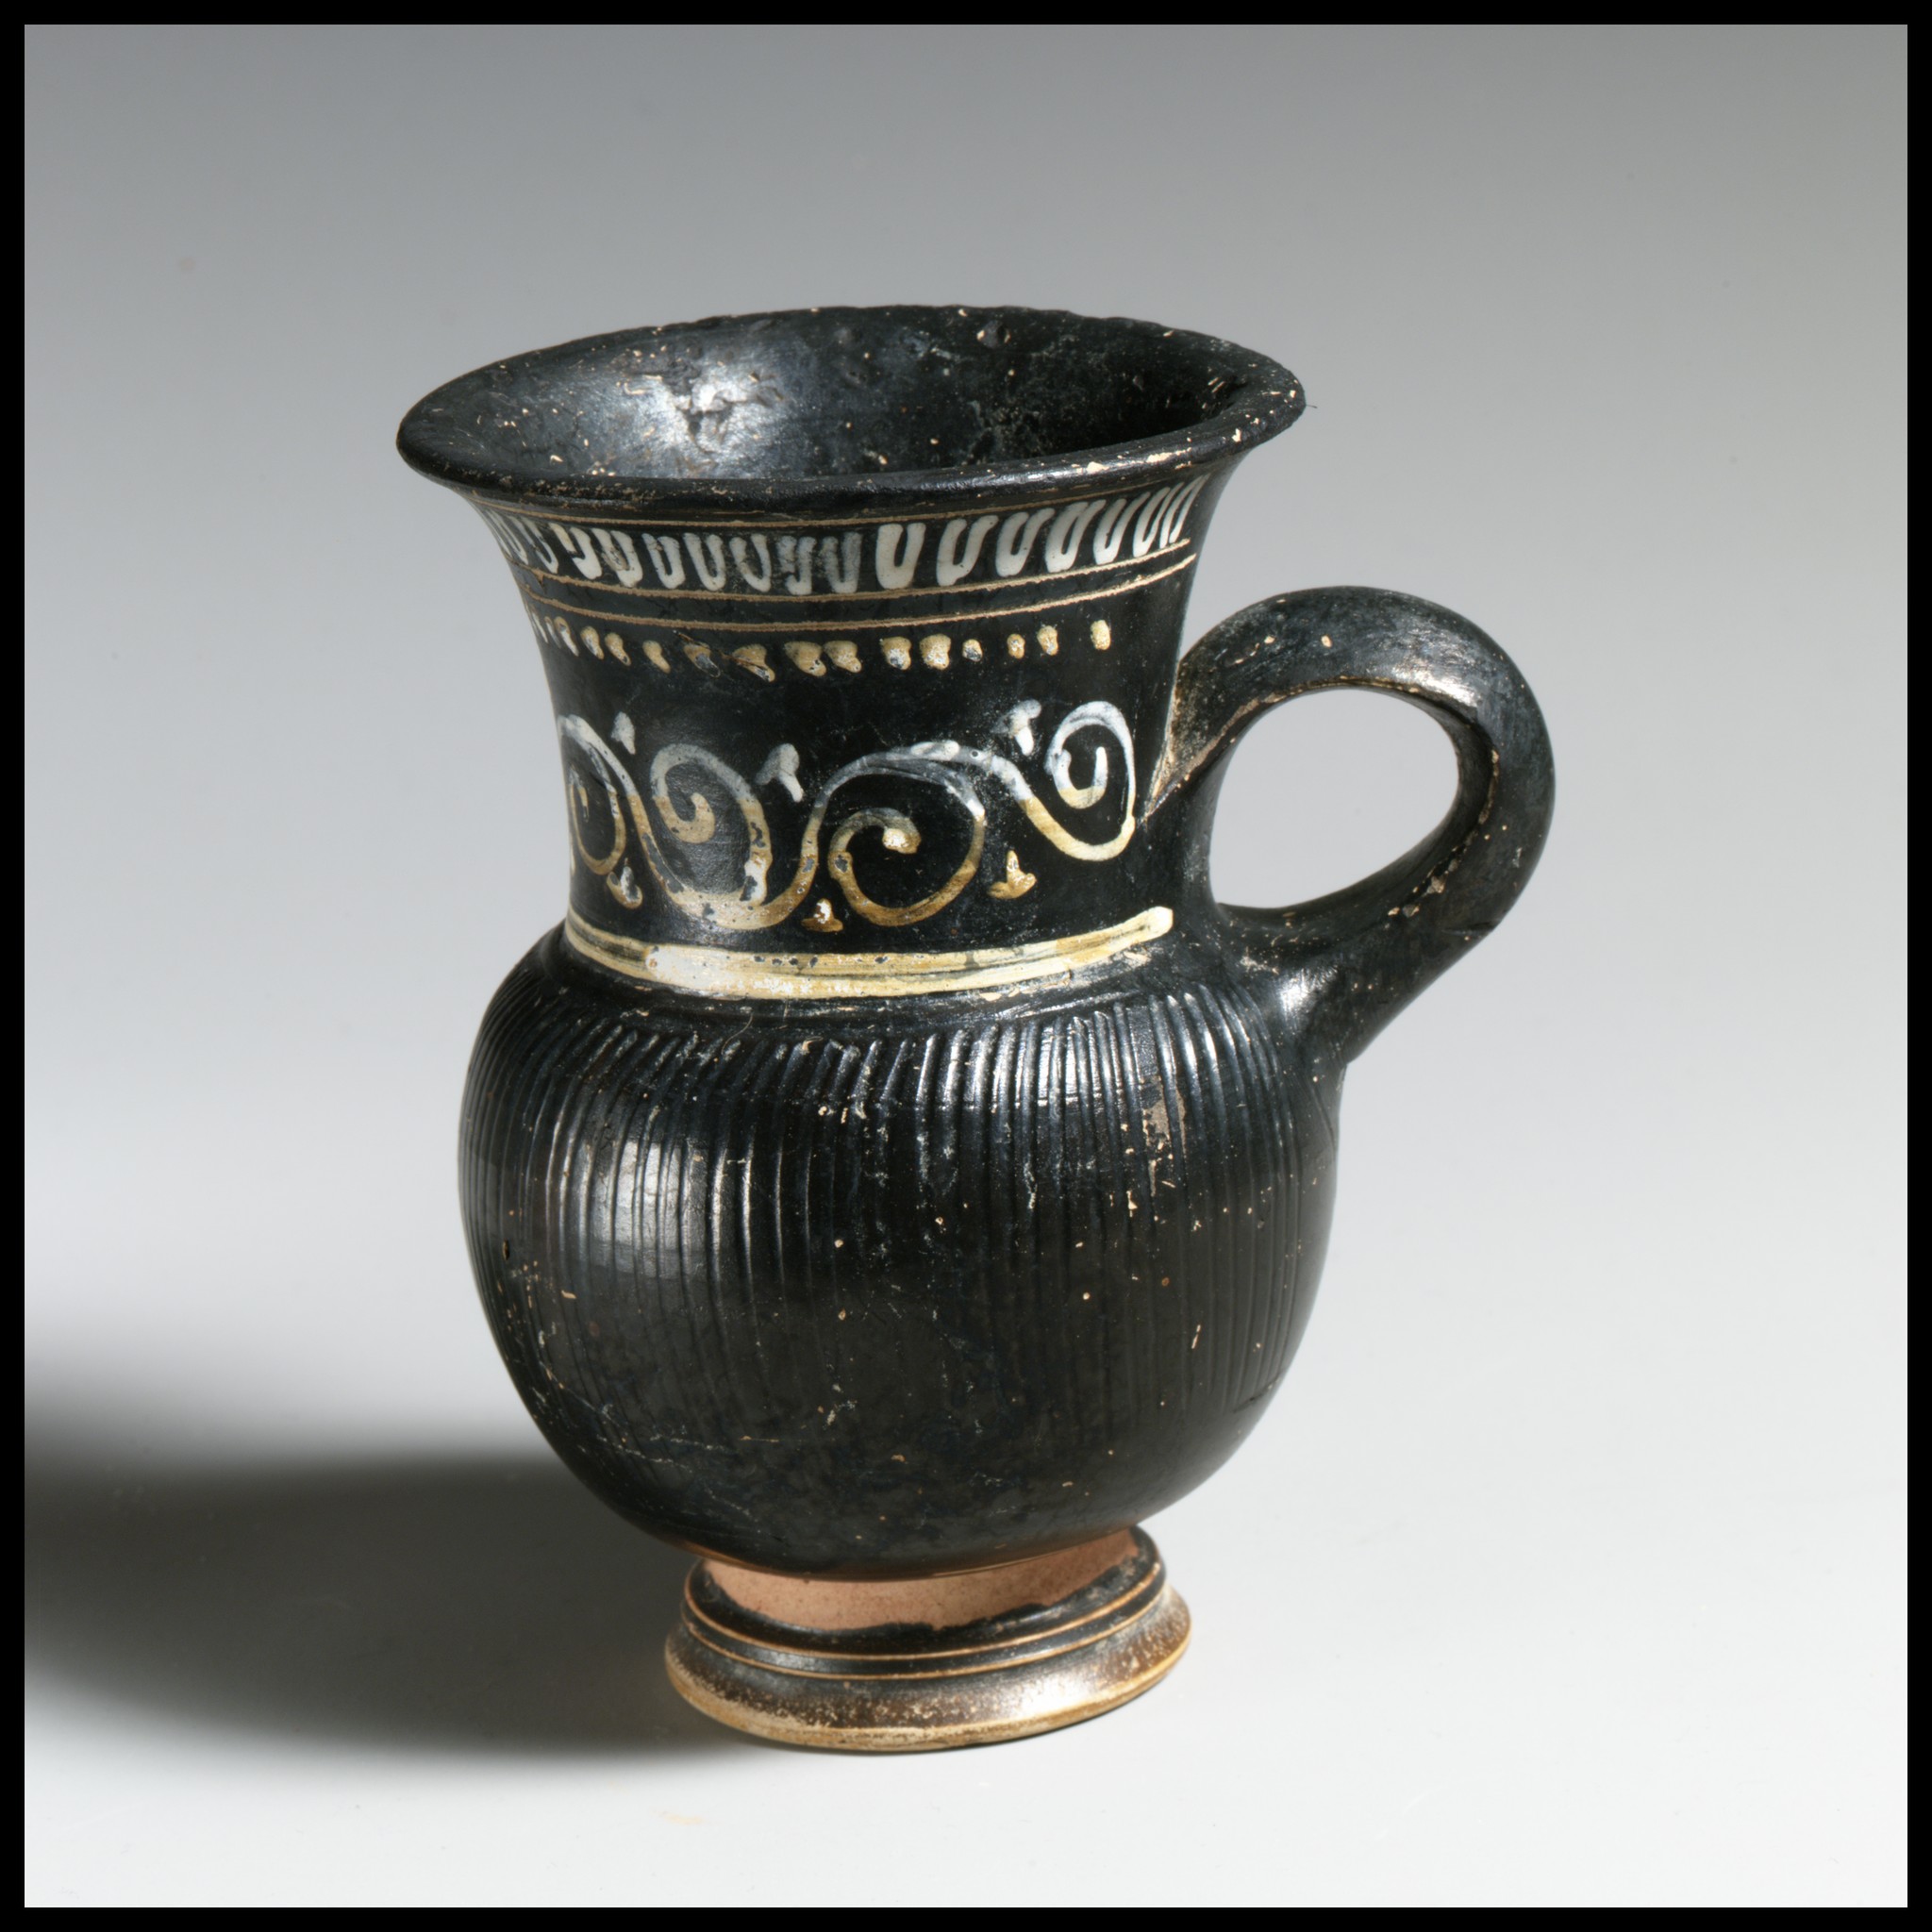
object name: oinochoe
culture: greek, south italian, apulian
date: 325-300 BCE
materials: terracotta